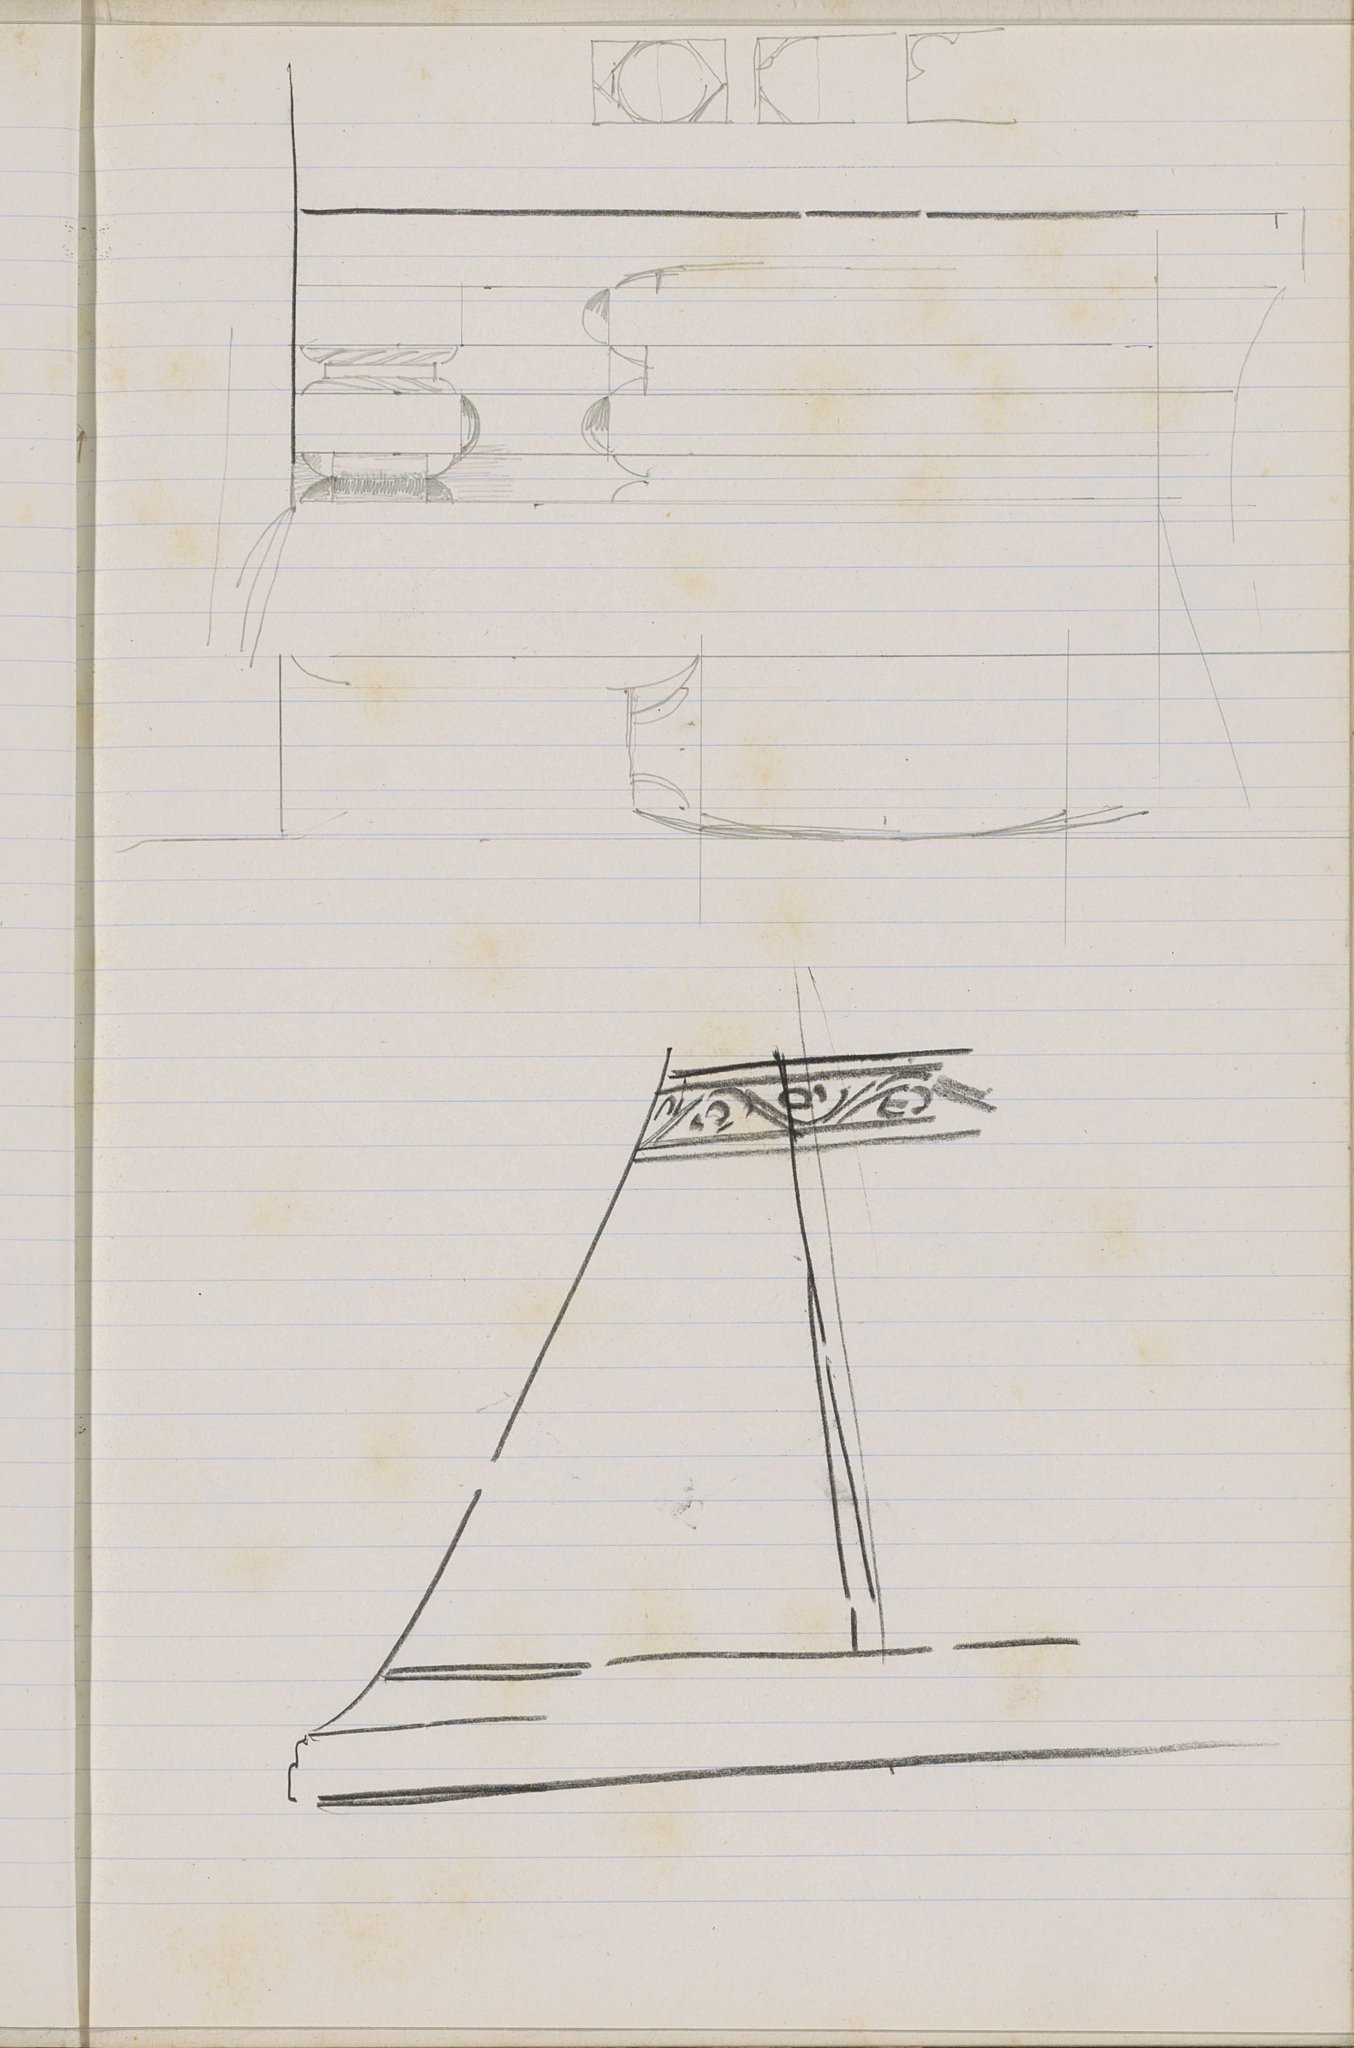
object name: sketchbook leaf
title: Studies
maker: gerrit willem dijsselhof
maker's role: designer, draughtsman, print maker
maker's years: 1866-1924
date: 1901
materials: chalk, pencil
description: Blad 68 recto uit een schetsboek met 79 bladen.